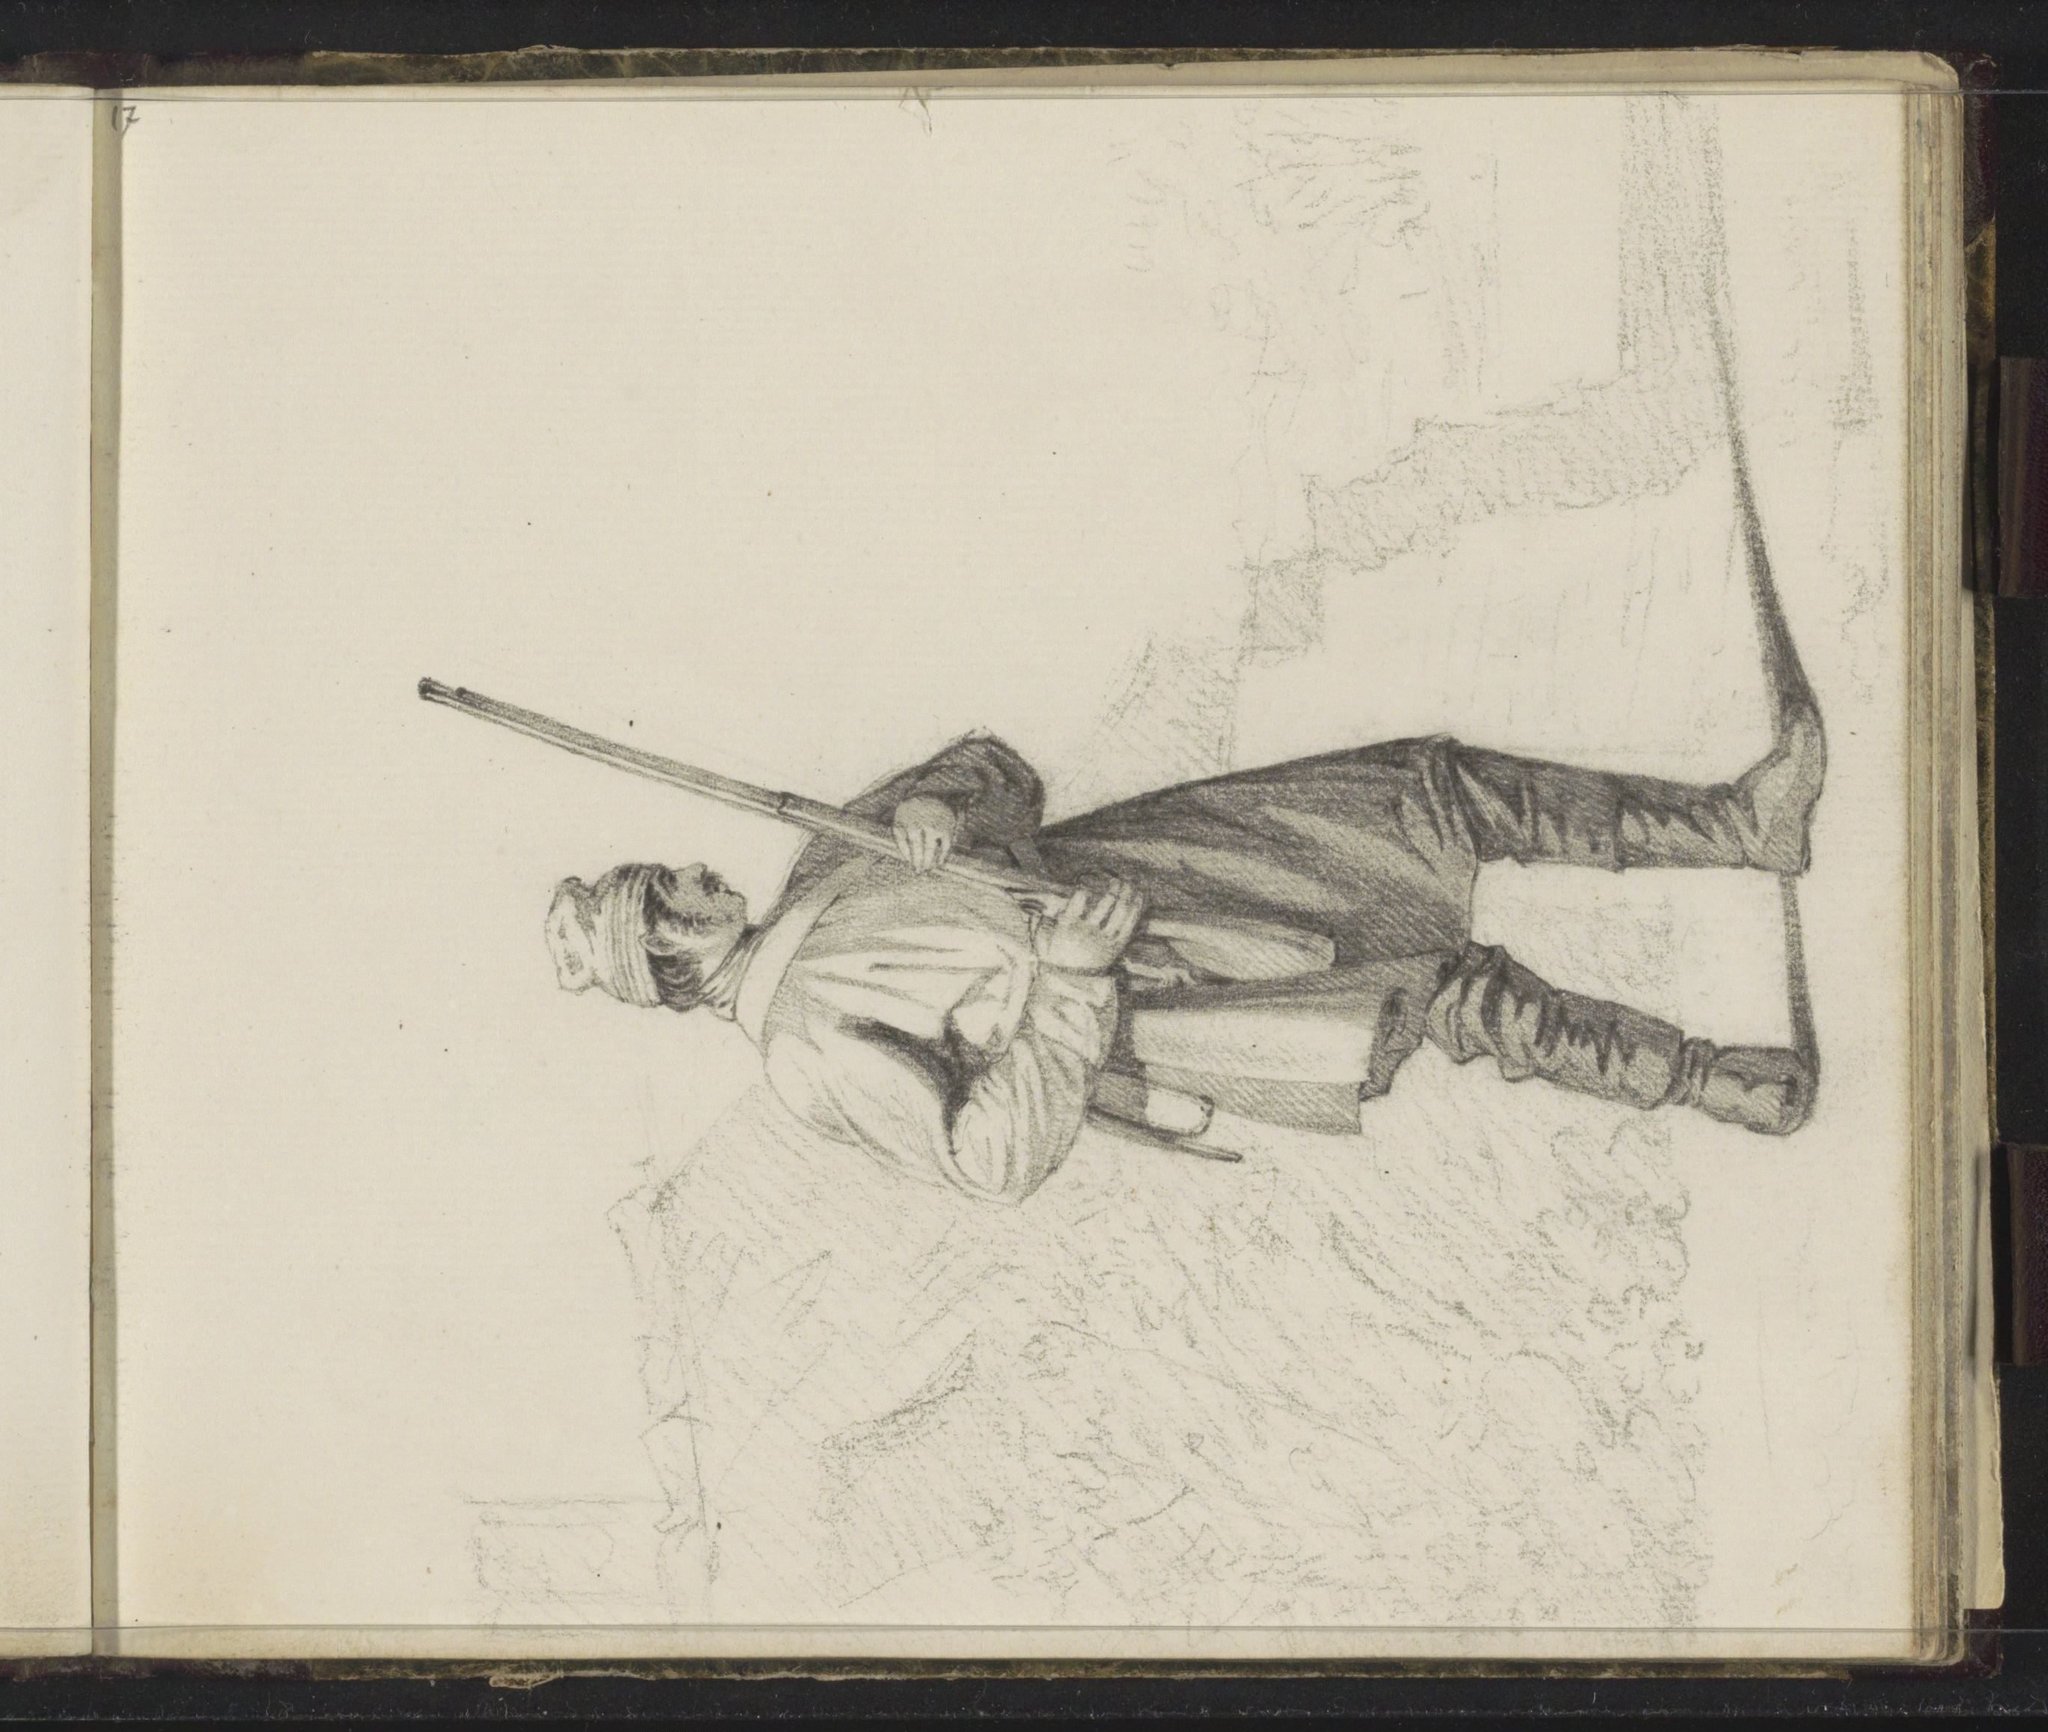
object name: sketchbook leaf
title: Man met een geweer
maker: hendrik abraham klinkhamer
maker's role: draughtsman, painter, print maker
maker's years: 1810-1872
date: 1820-1872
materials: chalk, paper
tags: firearms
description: Blad 17 recto uit een schetsboek met 39 bladen.